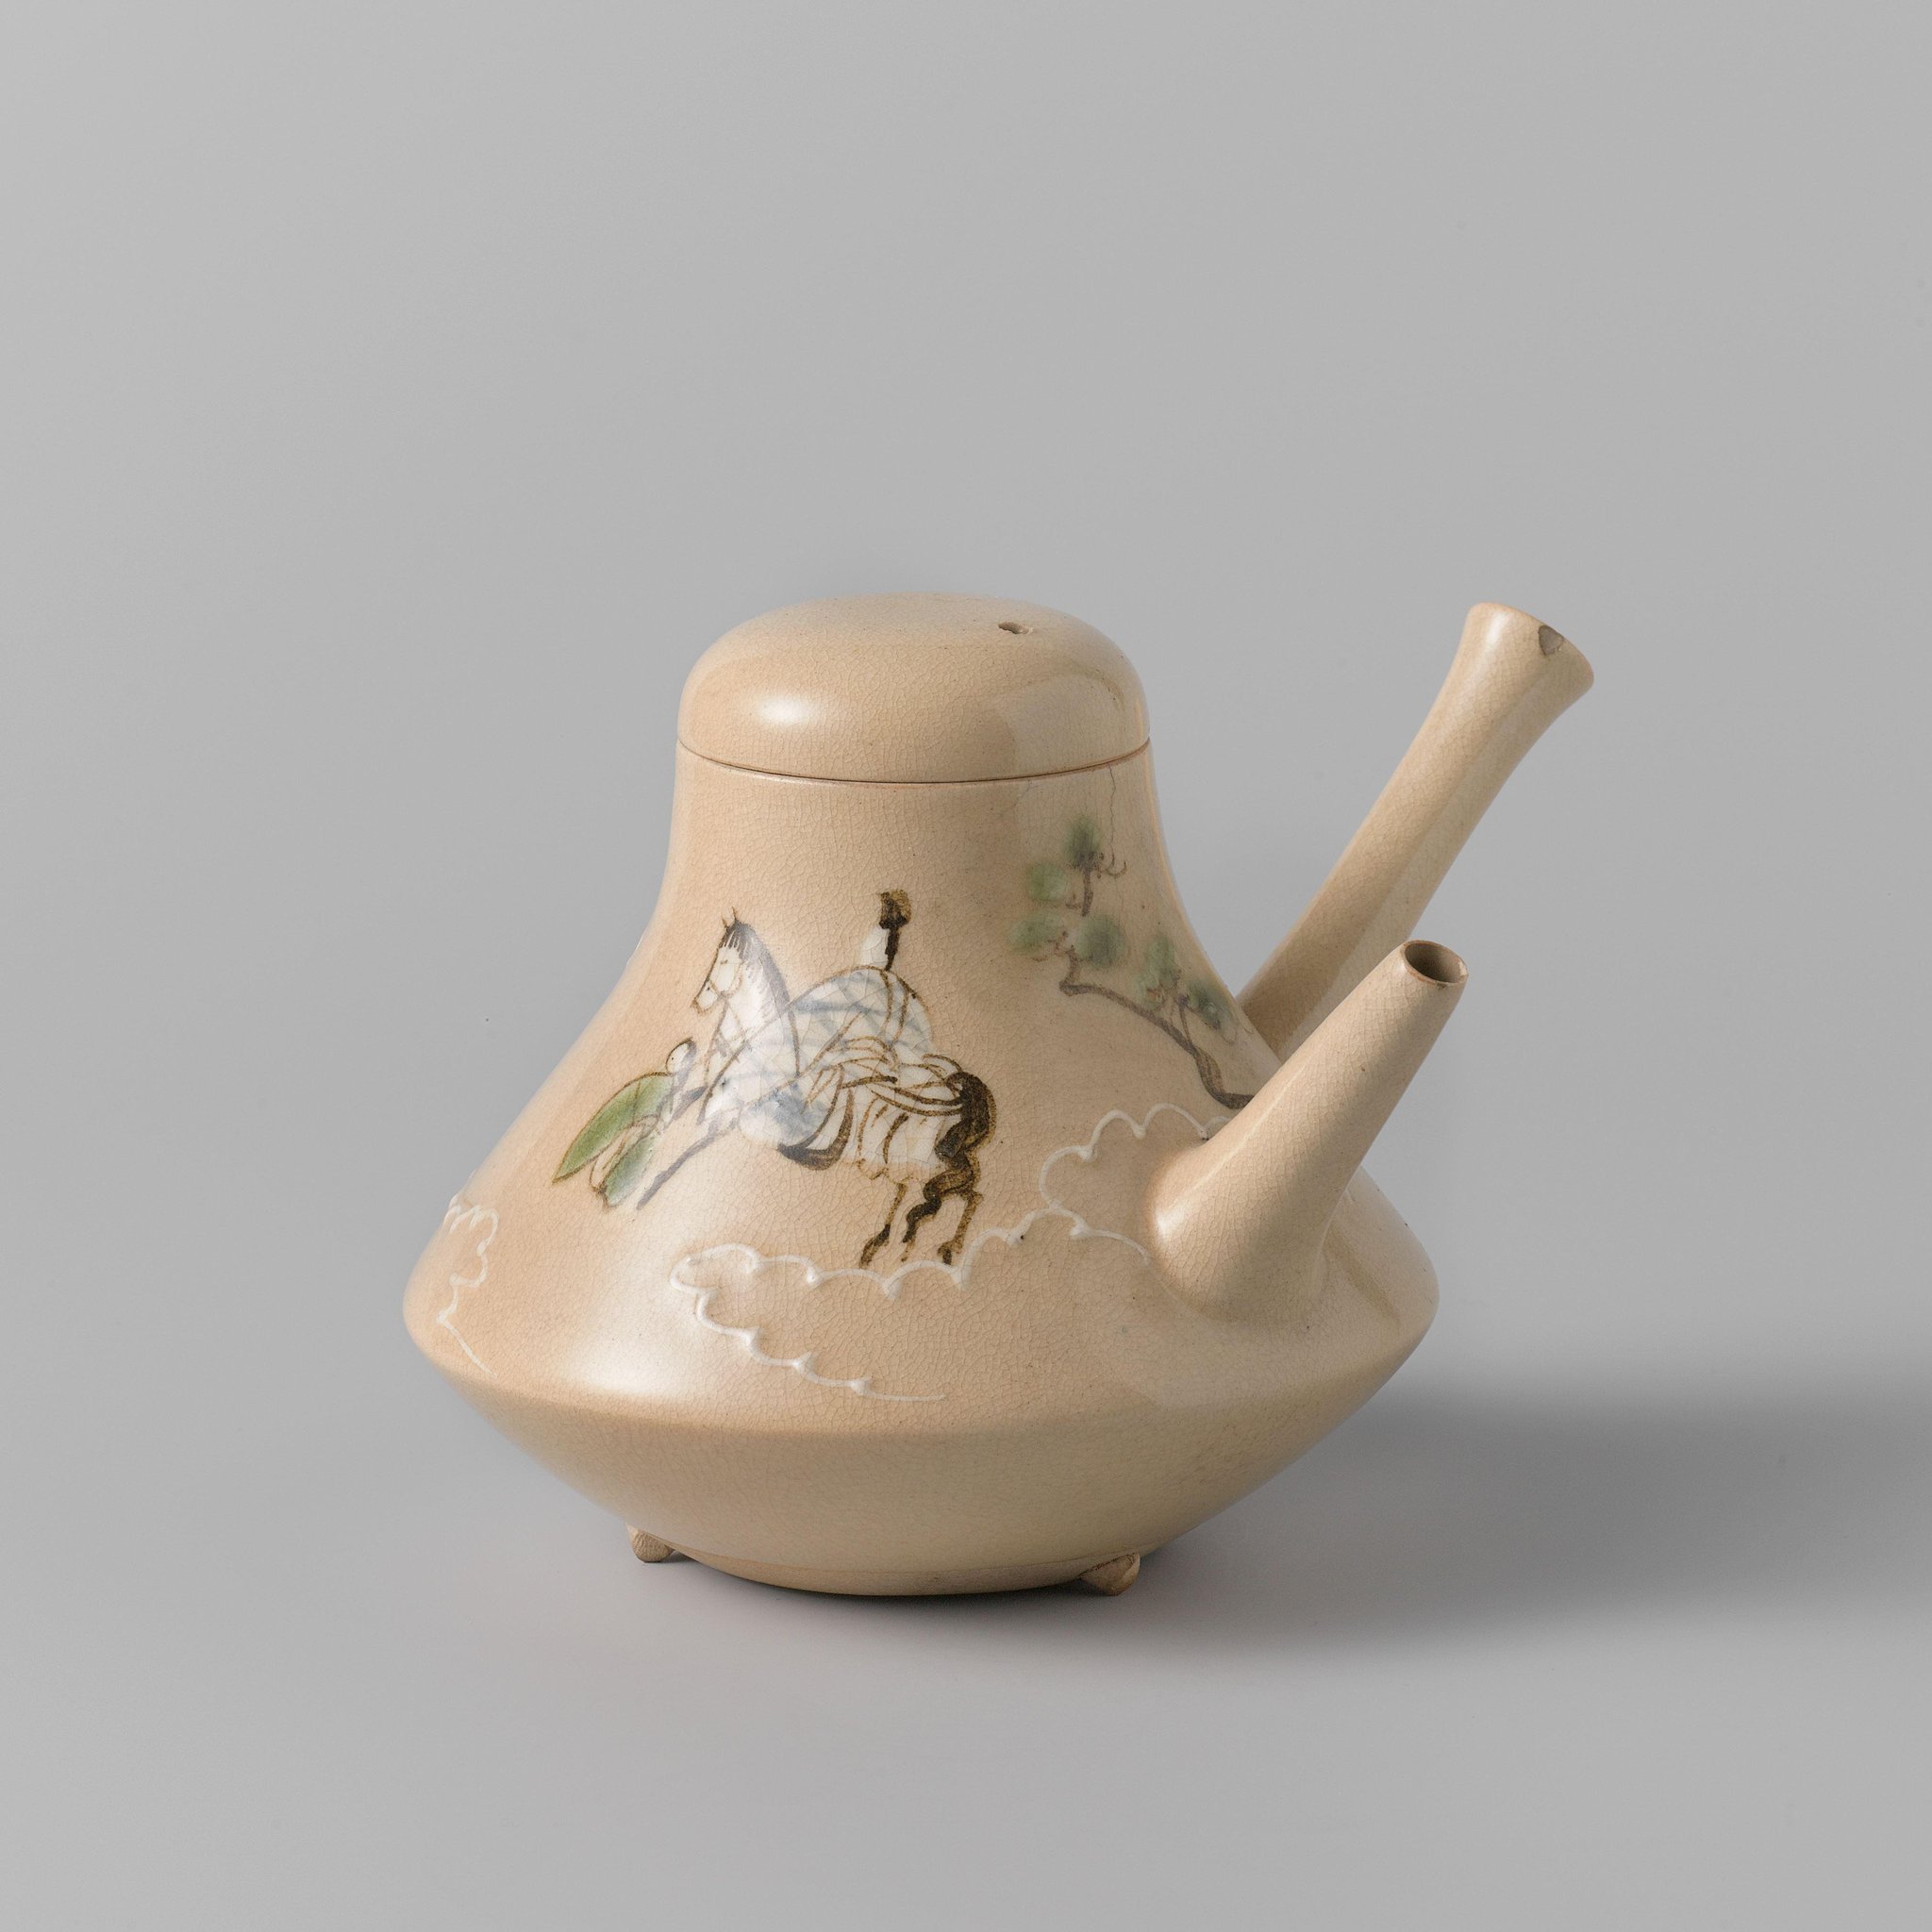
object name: teapot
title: Teapot with a horsemen in a landscape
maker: Anonymous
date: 1800-1825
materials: glaze, paint, stoneware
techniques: firing, turning, vitrification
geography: japan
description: Theepot van steengoed met een peervormig lichaam, drie kleine poten rond de voet en het handvat haaks op de tuit, bedekt met een beige glazuur en beschilderd onder het glazuur met een wit slib, bruin en groen. Op de buik een landschap met een ruiter, waarnaast een bediende. Aan de andere zijde een boom. Een chip in het handvat.